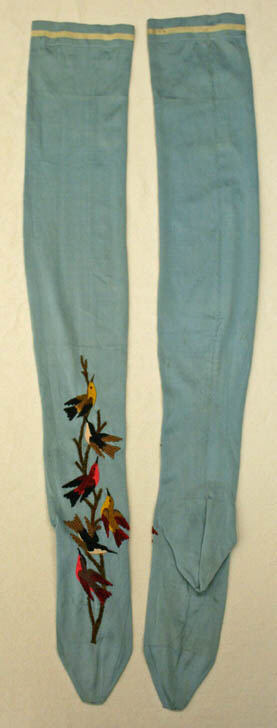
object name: stocking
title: Stockings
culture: french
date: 1885-1889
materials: silk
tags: birds